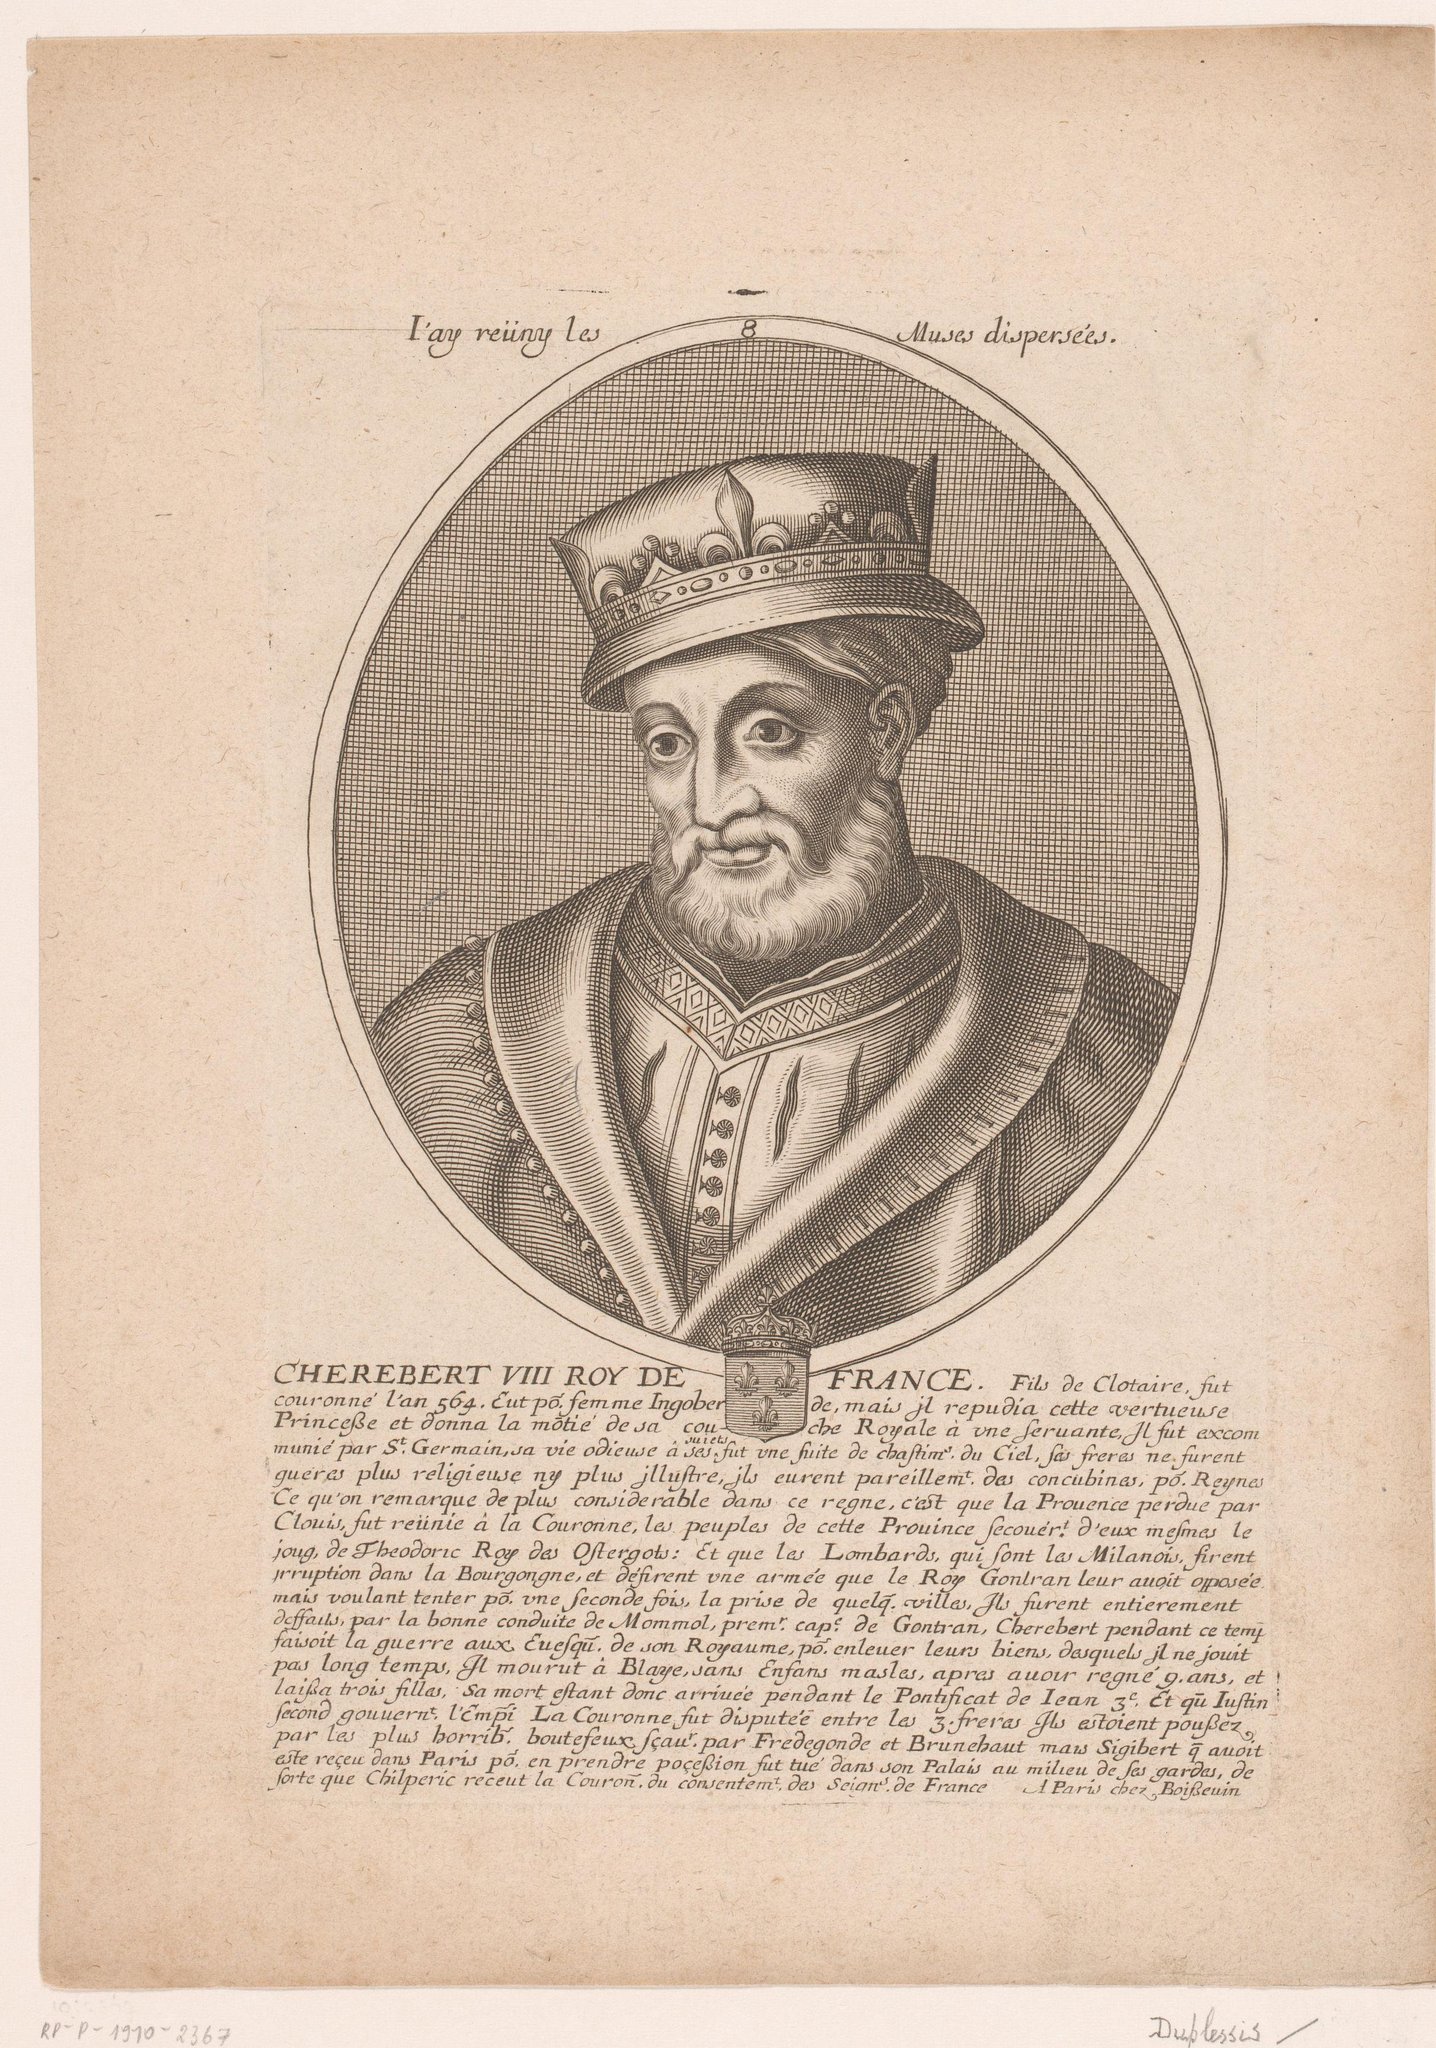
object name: print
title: Portret van Cherebert VIII van Frankrijk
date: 1633-1676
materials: paper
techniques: engraving, etching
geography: france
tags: ornament ~ medallion, historical persons, ruler, sovereign, armorial bearing, heraldry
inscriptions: collector's mark: Lugt 2228